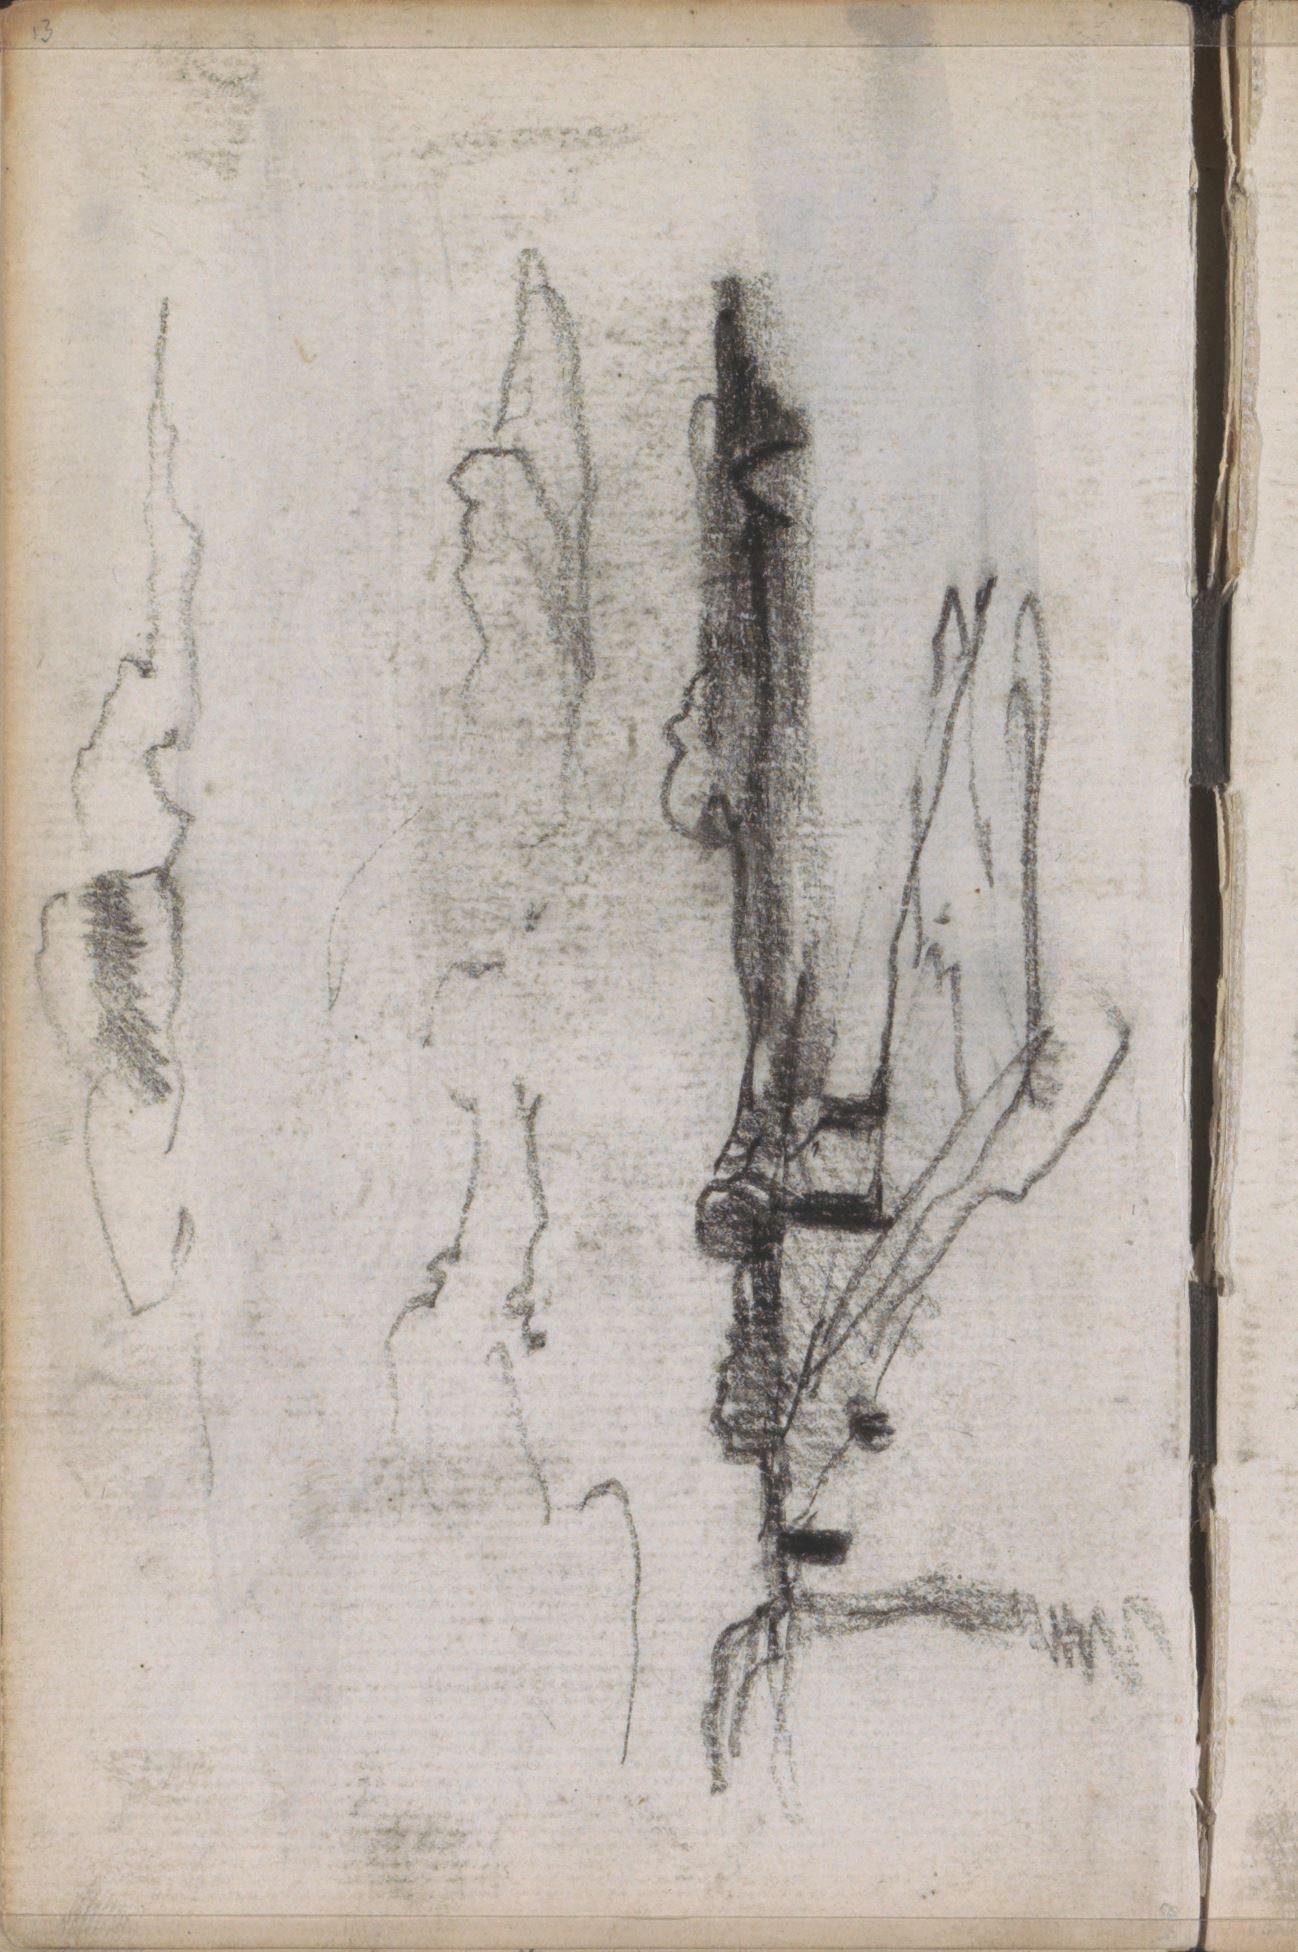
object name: sketchbook leaf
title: Landschap met figuren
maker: george hendrik breitner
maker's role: draughtsman, painter, print maker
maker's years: 1857-1923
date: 1884-1886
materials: chalk, paper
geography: drenthe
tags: landscapes (+ landscape with figures, staffage), dog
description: Pagina 13 uit een schetsboek met 67 bladen vervaardigd in Drenthe.